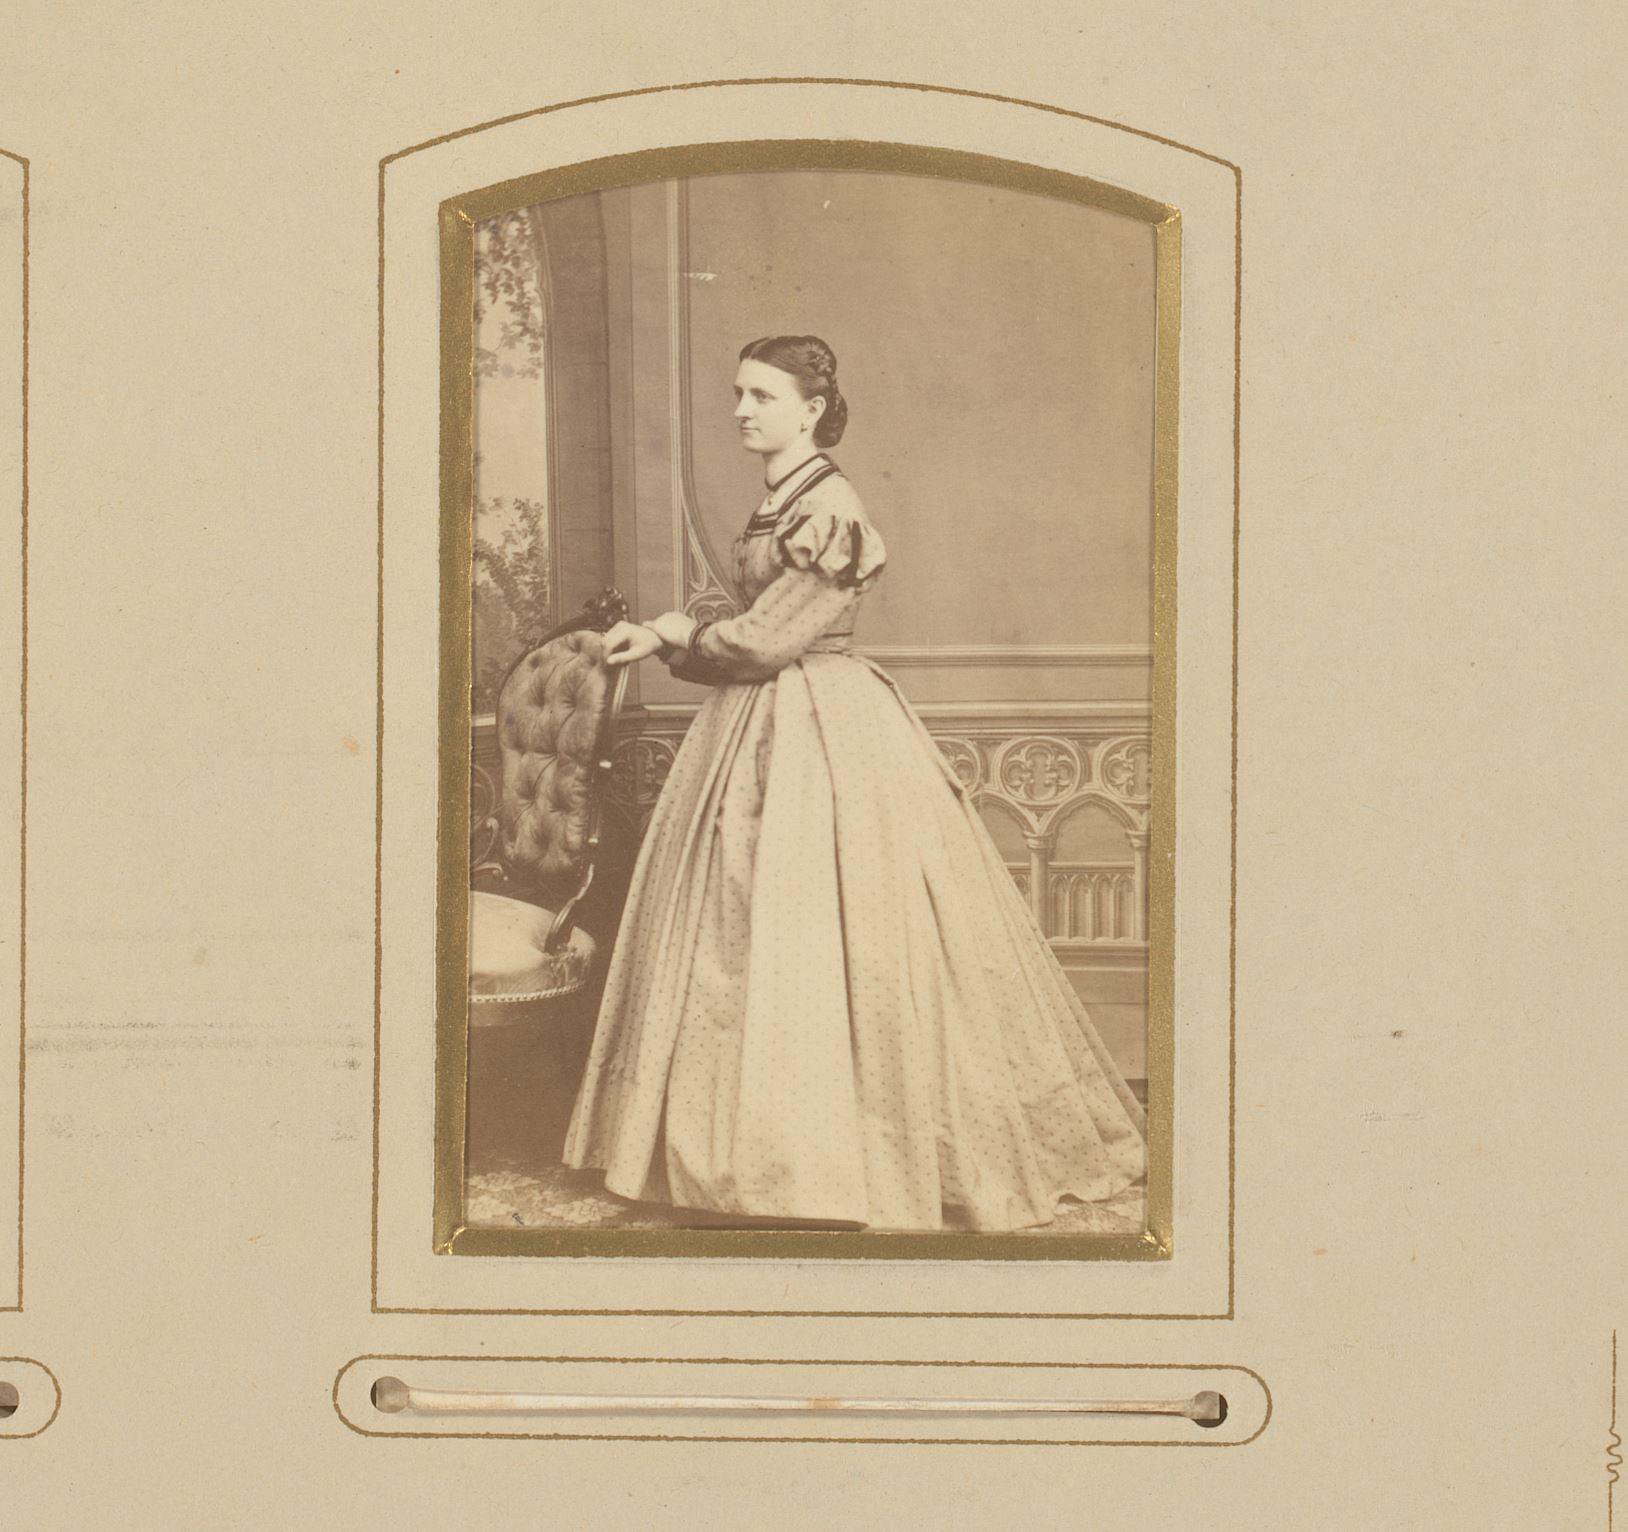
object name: carte de visite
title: Portret van een vrouw in japon, staand bij een stoel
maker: s. mauer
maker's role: fotograaf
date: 1850-1900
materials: cardboard, photographic support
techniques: albumen print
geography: coburg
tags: historical persons - bb - woman, dress, gown, chair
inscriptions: inscription: ‘Photographisches Atelier/ S. MAUER/ COBURG.’